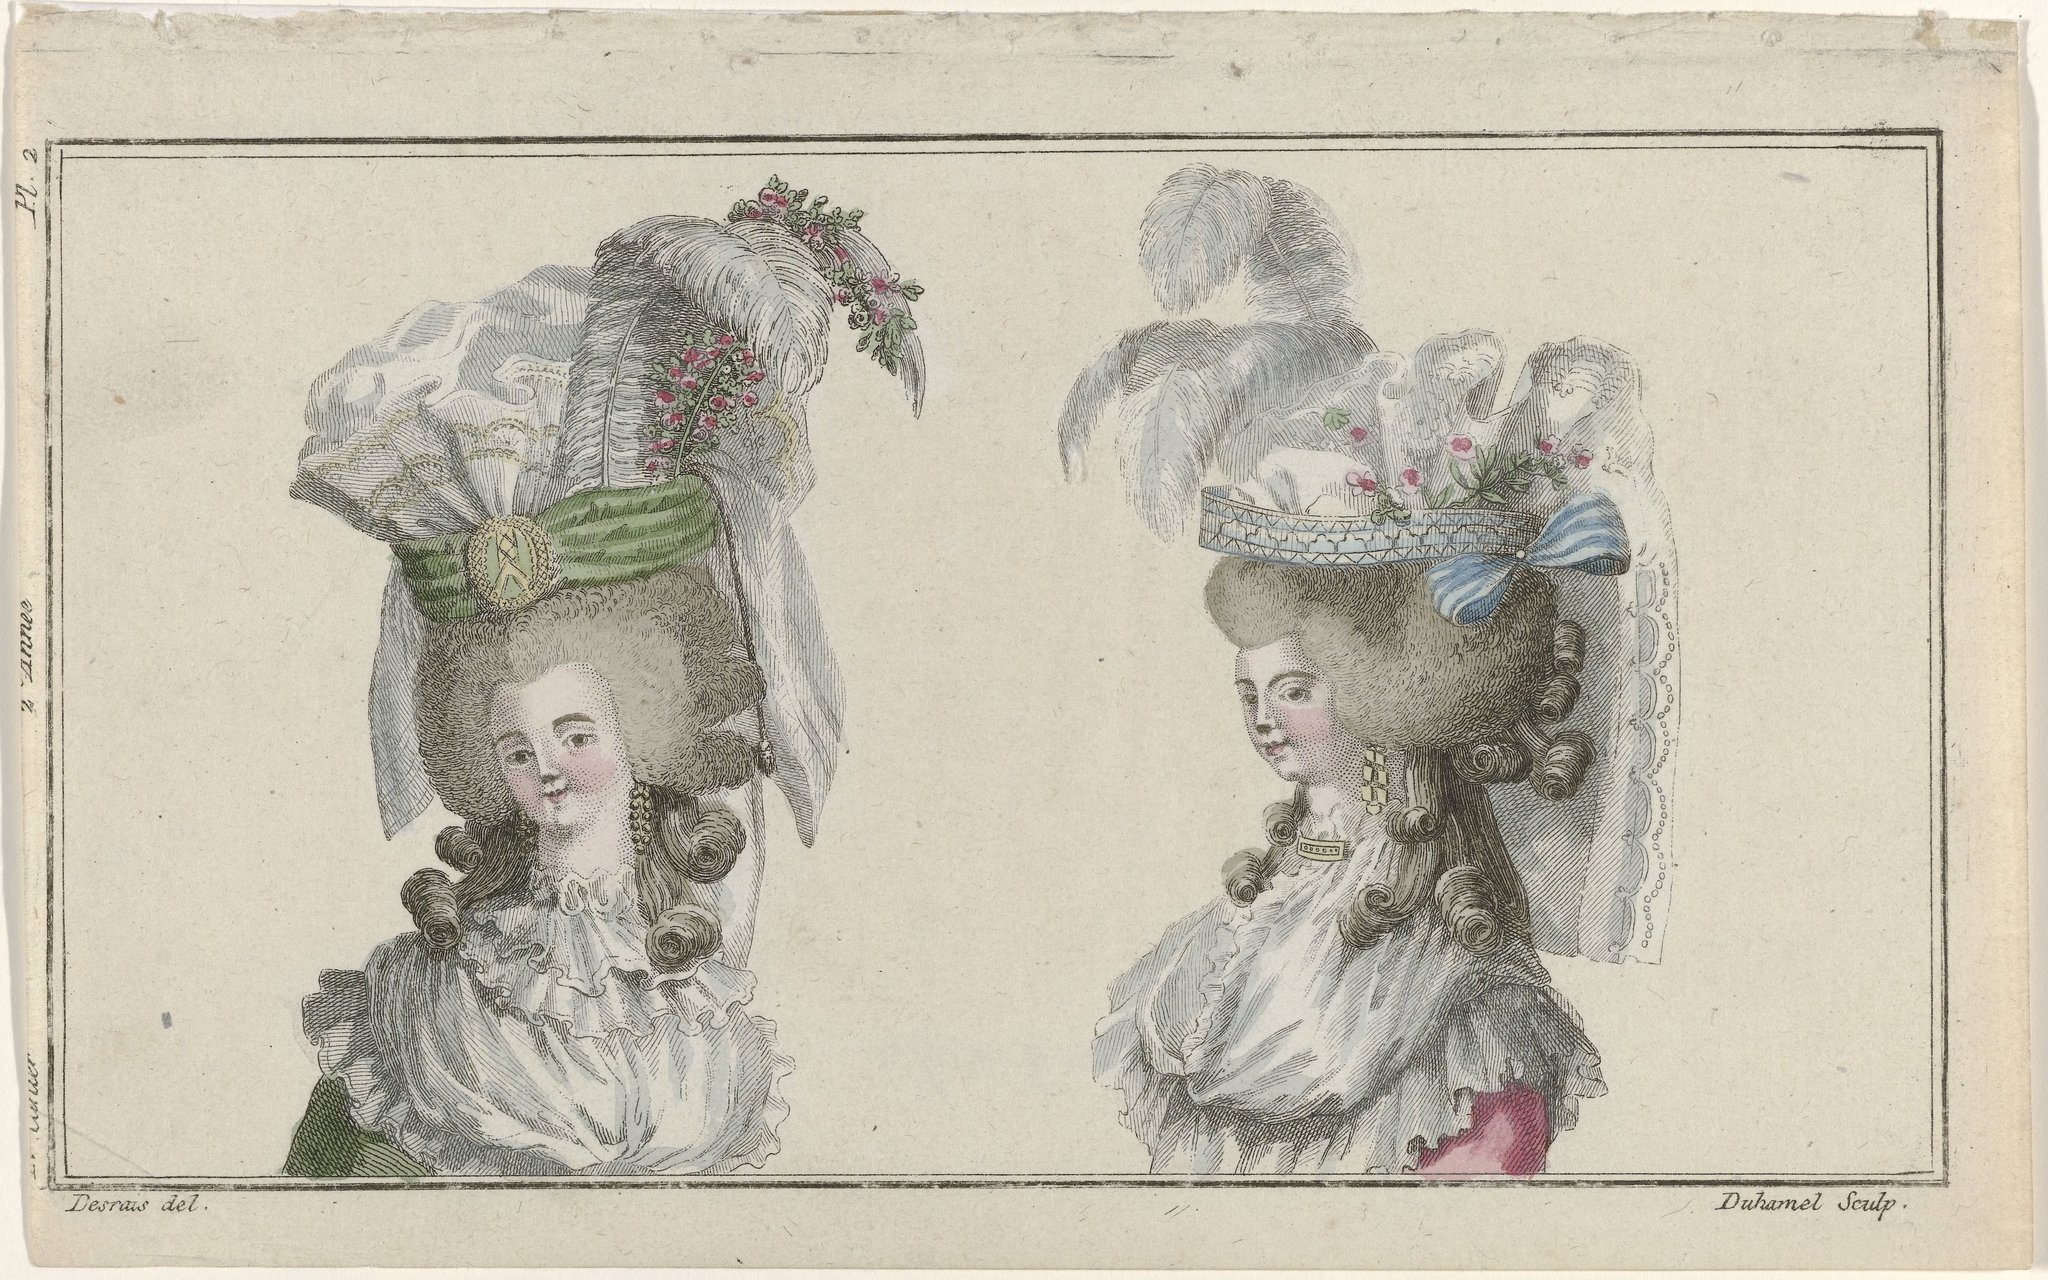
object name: fashion print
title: Magasin des Modes Nouvelles Françaises et Anglaises, 20 novembre 1786, 2e Année, 1er cahier, Pl. 2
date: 1786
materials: paper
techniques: engraving, hand coloring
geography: paris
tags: ear-rings (+ women's clothes), border, ribbon, braid (+ women's clothes), styles of hairdress - aa - ~ women, head-gear: cap (+ women's clothes), fashion plates, piece of clothing covering the breast or décolleté (fichu) (+ women's clothes), neck-gear ~ clothing (+ women's clothes)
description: Twee vrouwenbustes, met op het opgekapte haar een 'bonnet à la Randan' (links) met groen lint en een 'bonnet à la Chinoise' (rechts). De prent maakt deel uit van het 2e Année, 1er Cahier, uit de serie Magasin des Modes Nouvelles Françaises et Anglaises. De serie bestaat uit 172 modeprenten, uitgegeven door Buisson, Parijs, 20 novembre 1786 - 21 décembre 1789.